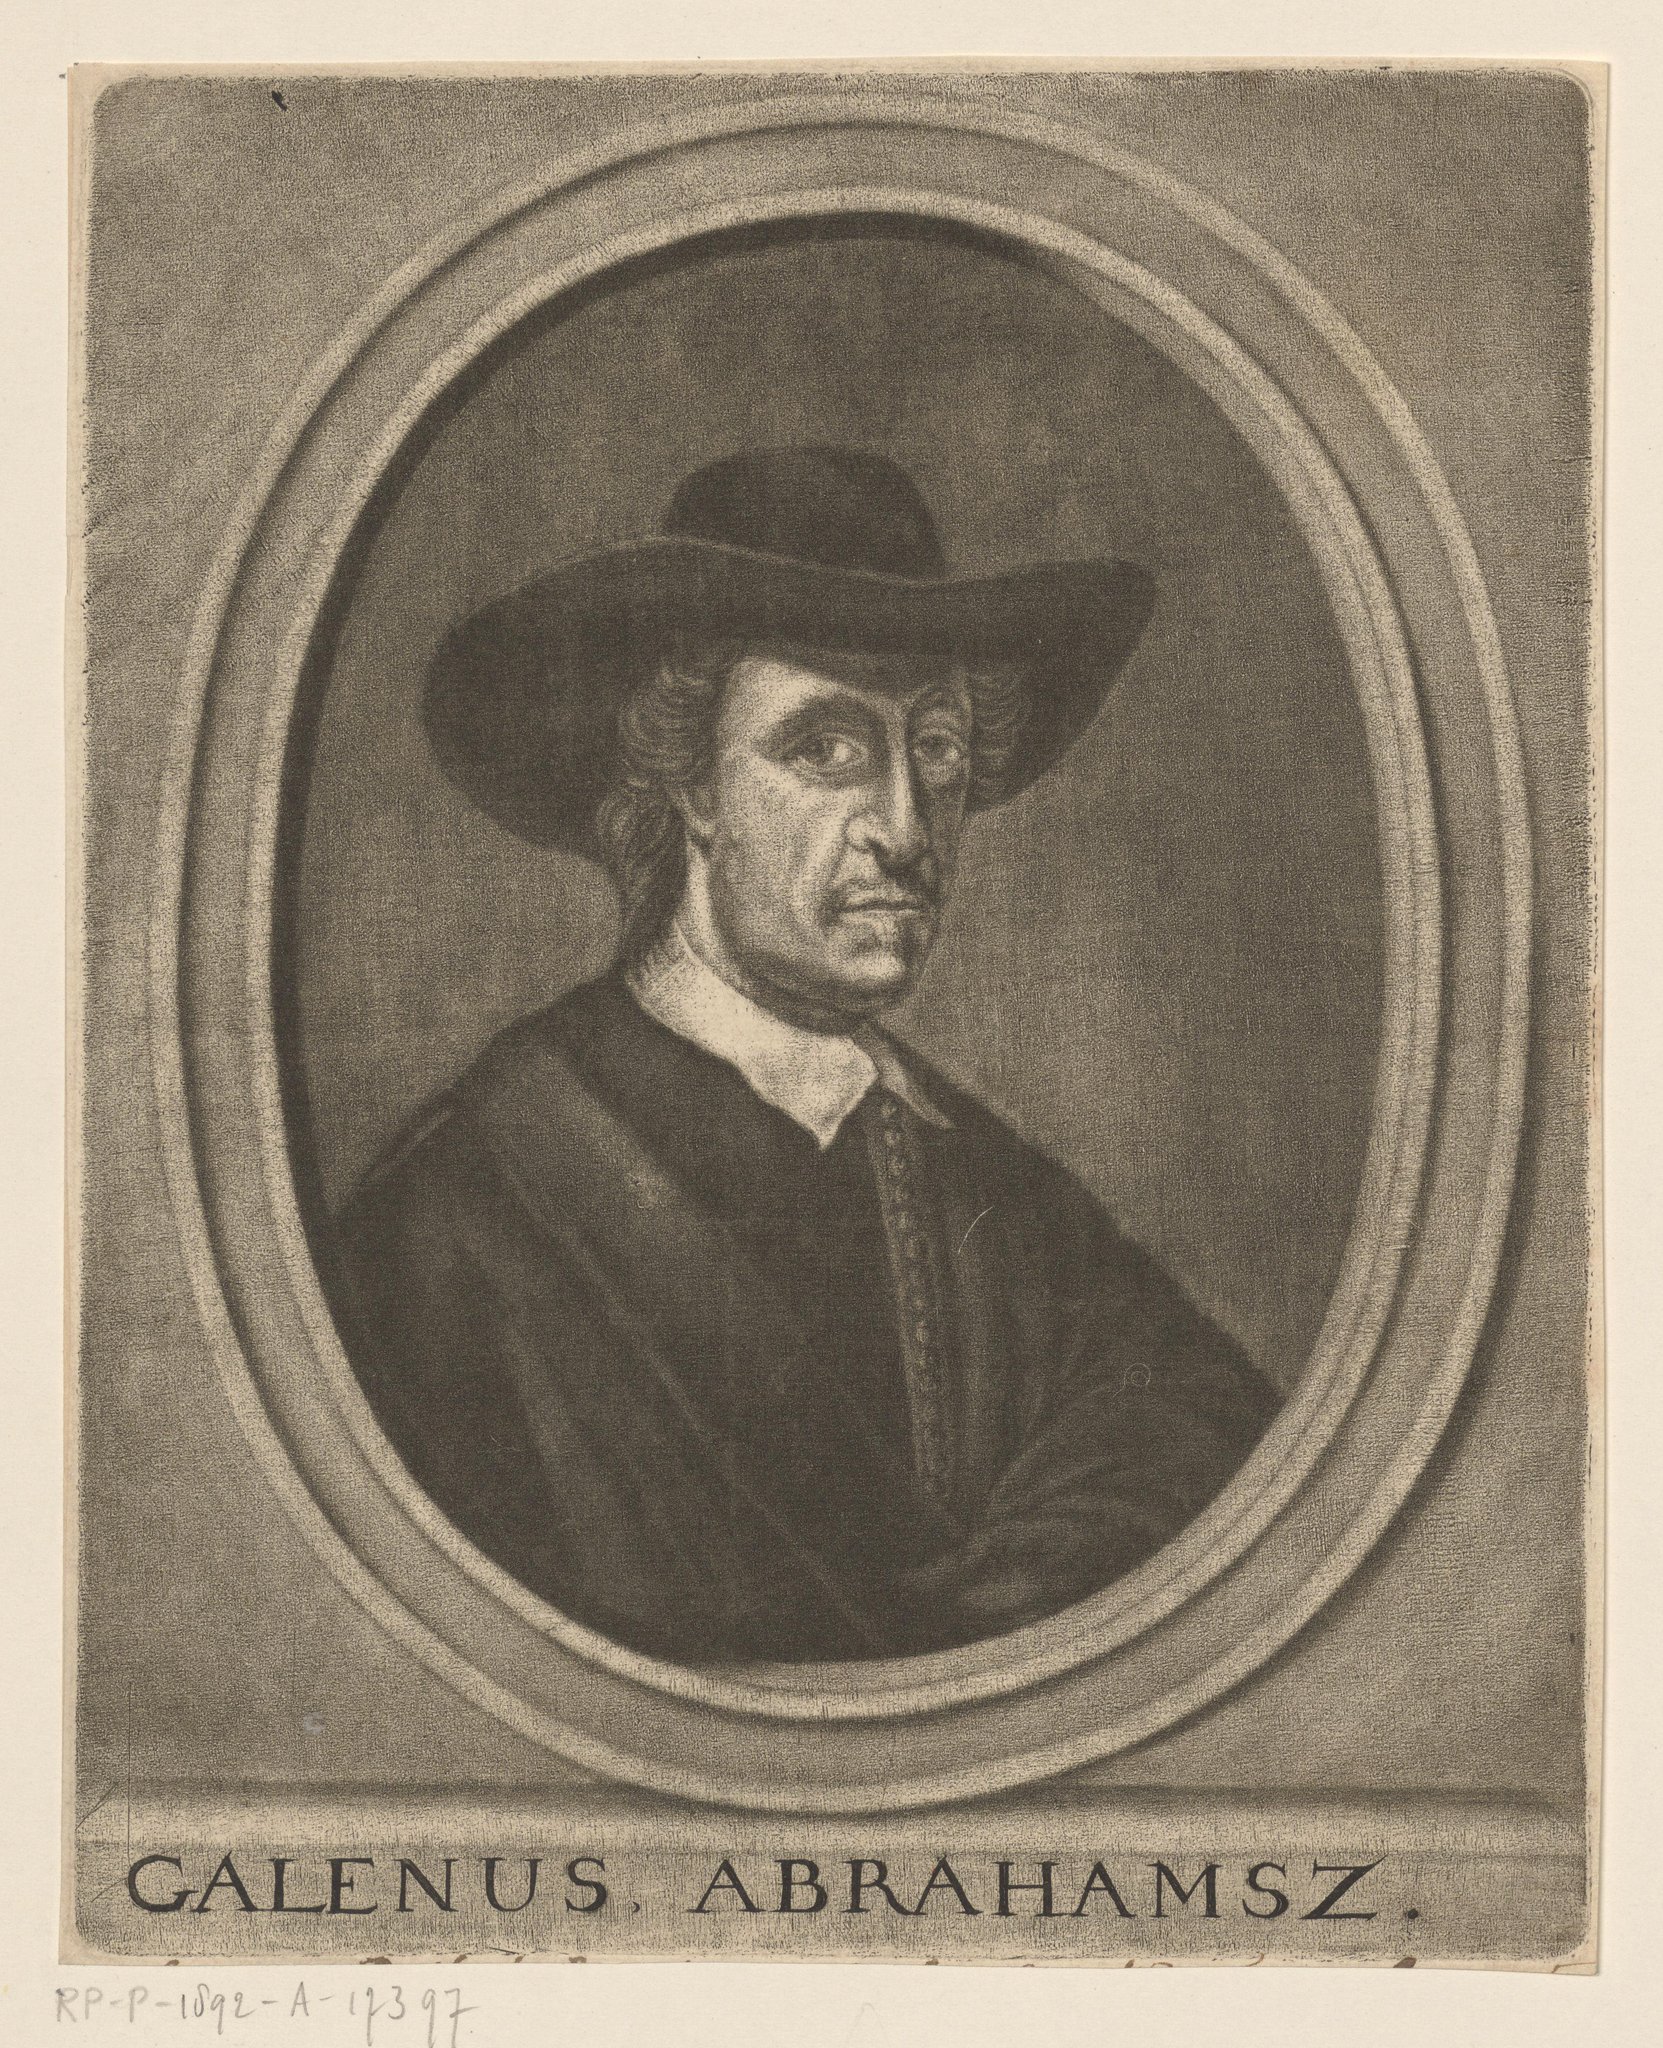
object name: print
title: Portret van Galenus Abrahamsz. de Haan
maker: anna maria van schurman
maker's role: draughtsman, print maker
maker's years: 1607-1678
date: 1660-1678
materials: paper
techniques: mezzotint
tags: galenus abrahamsz. de haan, theologian, historical persons, medicine, medical science (+ portrait of scholar, scientist)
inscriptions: collector's mark: Lugt 2228